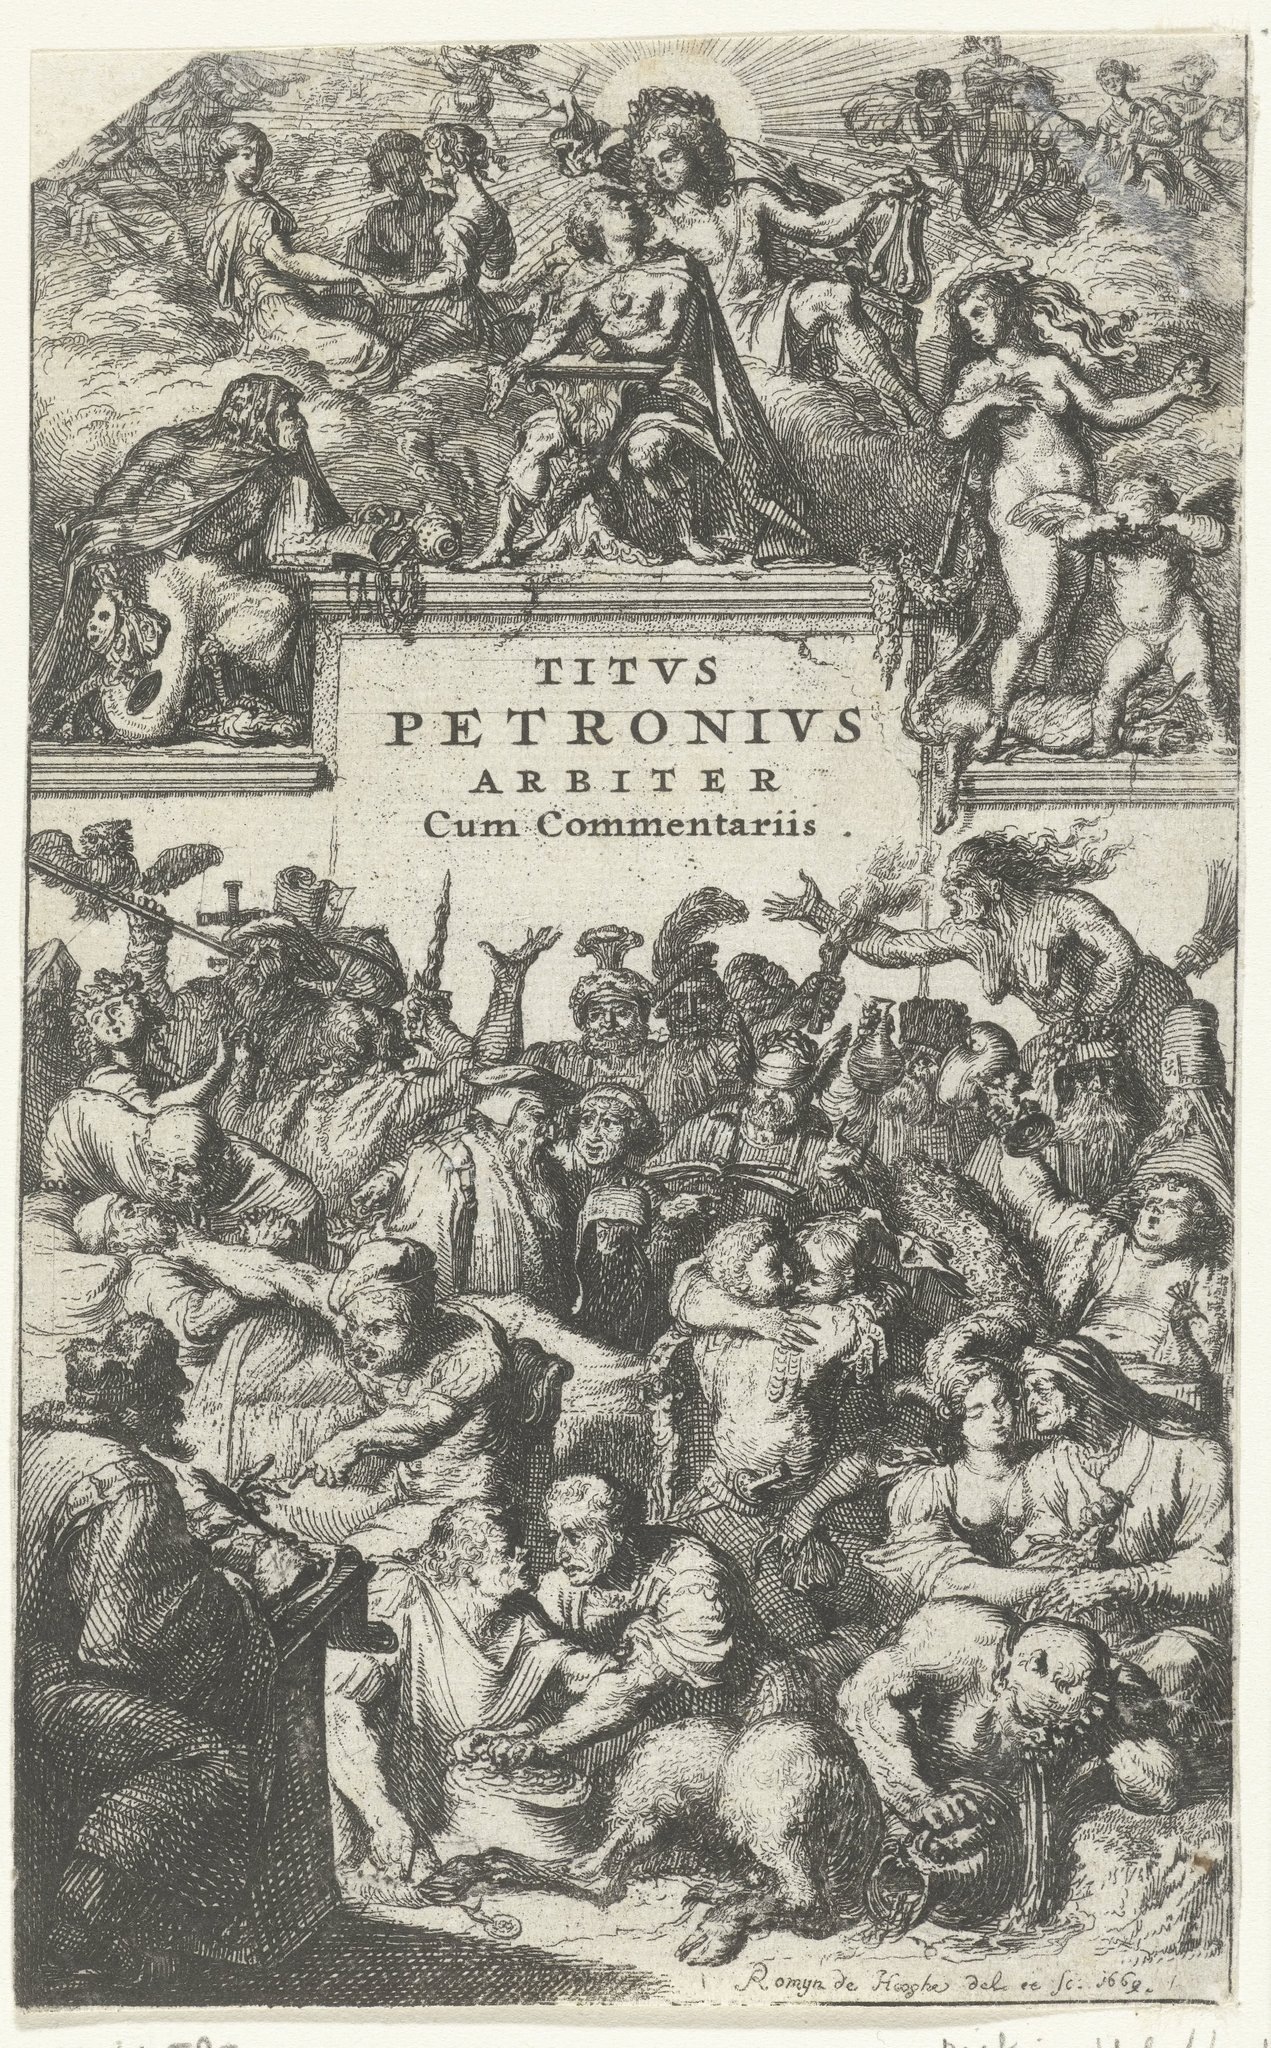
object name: titelprent, frontispice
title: Titelprent voor 'Satyricon' van Titus Petronius Arbiter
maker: romeyn de hooghe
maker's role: draughtsman, goldsmith, painter, print maker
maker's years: 1645-1708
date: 1669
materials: paper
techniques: etching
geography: amsterdam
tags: (story of) apollo (phoebus), (lovers) kissing each other, vomiting, robber, writer, poet, author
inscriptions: collector's mark: Lugt 2228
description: Titelprent voor: Titus Petronius Arbiter, 'Satyricon' (= 'Titi Petronii Arbitri eqvitis Romani Satyricon, cum fragmento nuper Tragurii reperto. Accedunt diversorum poëtarum Lusus in Priapum ... / omnia commentariis, & notis doctorum virorum illustrata'), vertaald door Michael Hadrianides (Amsterdam: Joan I Blaeu, 1669). Klinkert, C.